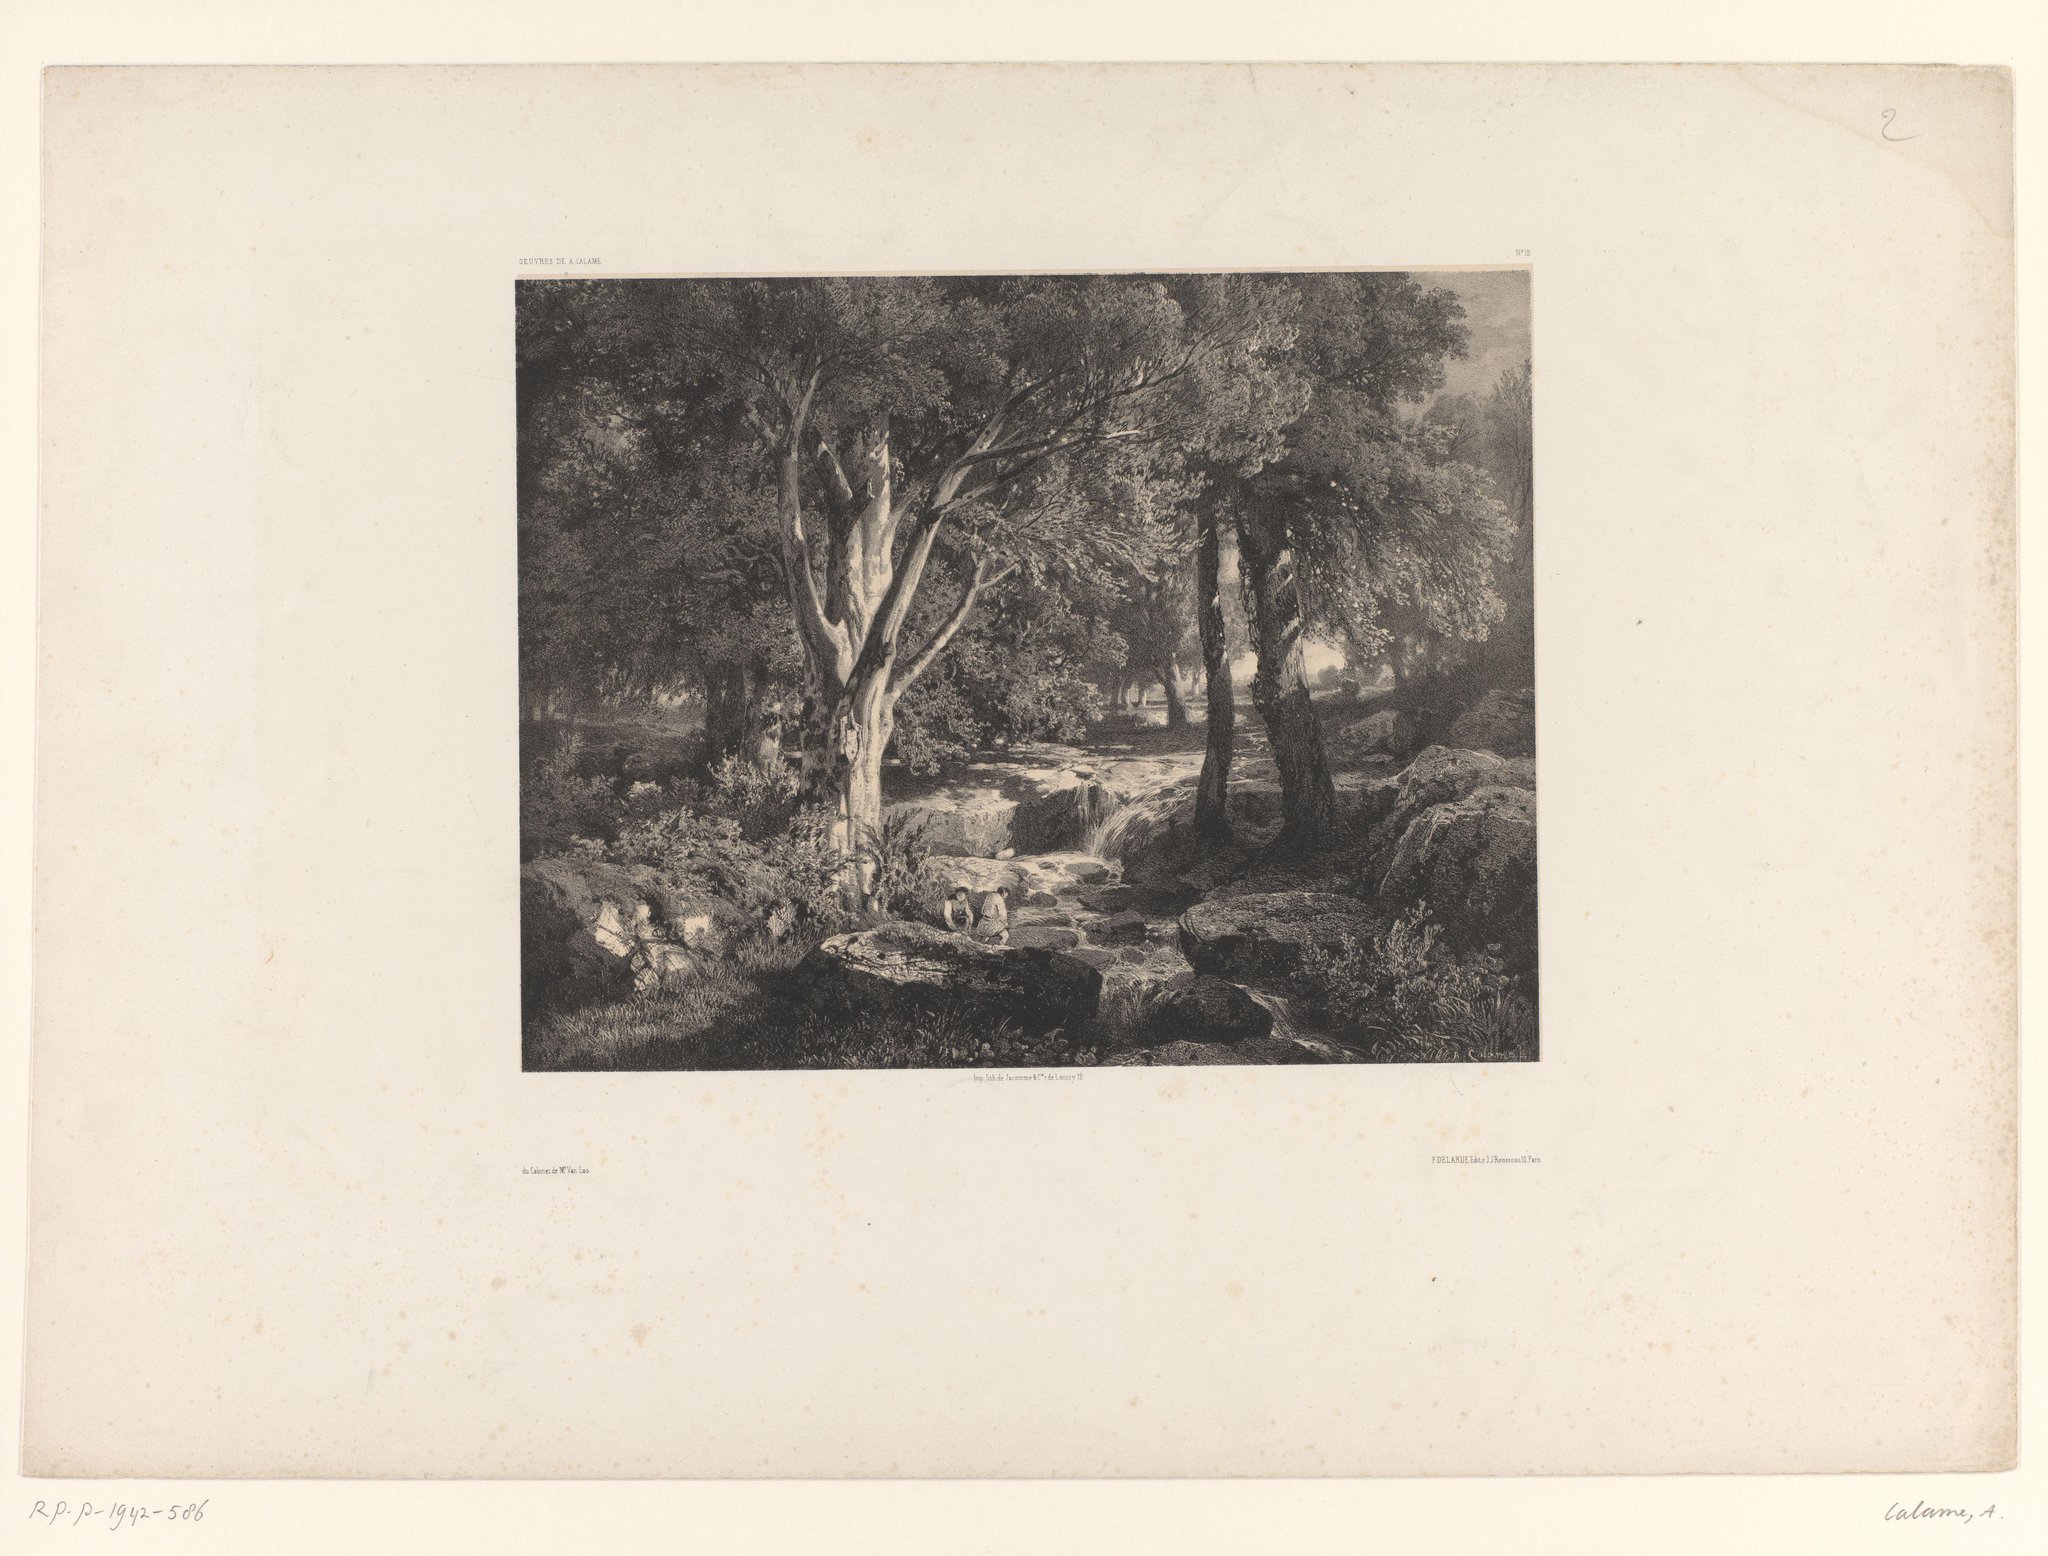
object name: print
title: Landschappen door A. Calame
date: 1852-1855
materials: paper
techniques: lithograph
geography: paris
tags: brook, forest, wood (+ landscape with figures, staffage)